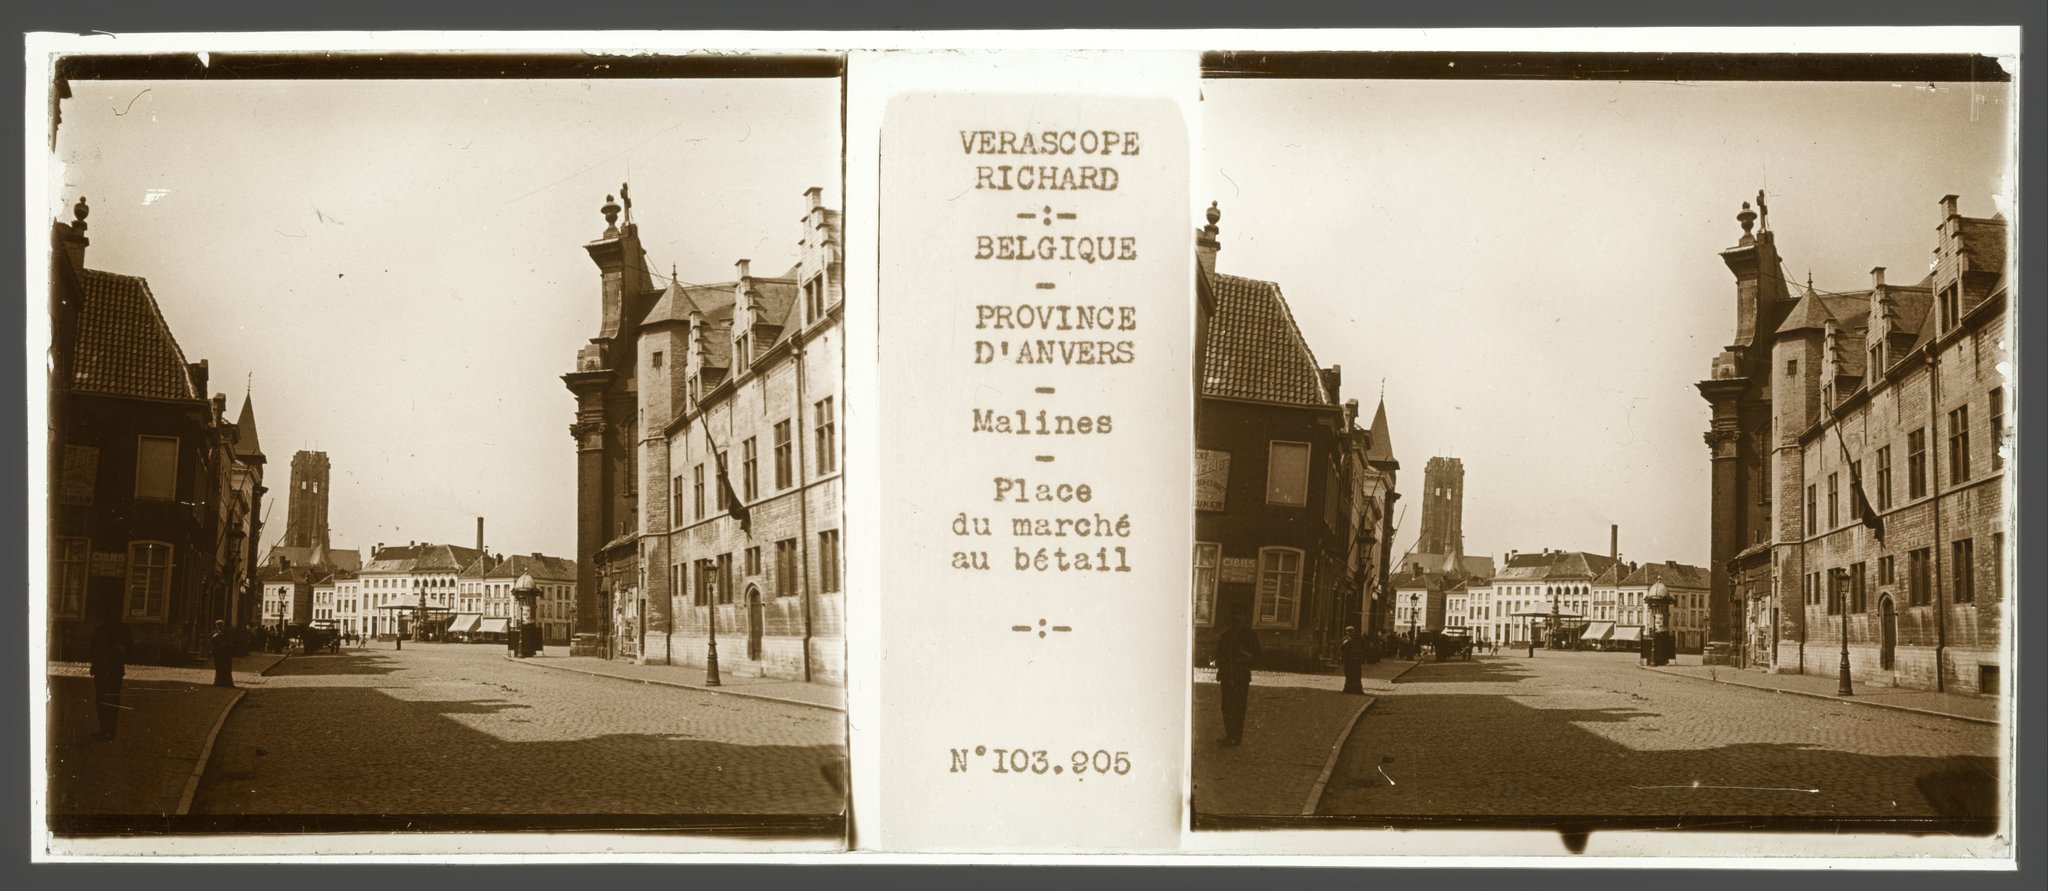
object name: stereoscopic photograph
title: Gezicht op de Veemarkt te Mechelen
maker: Anonymous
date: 1893-1920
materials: glass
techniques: gelatin silver transparency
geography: mechelen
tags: square, place, circus, etc., mechelen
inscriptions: number: ‘No 103.905’